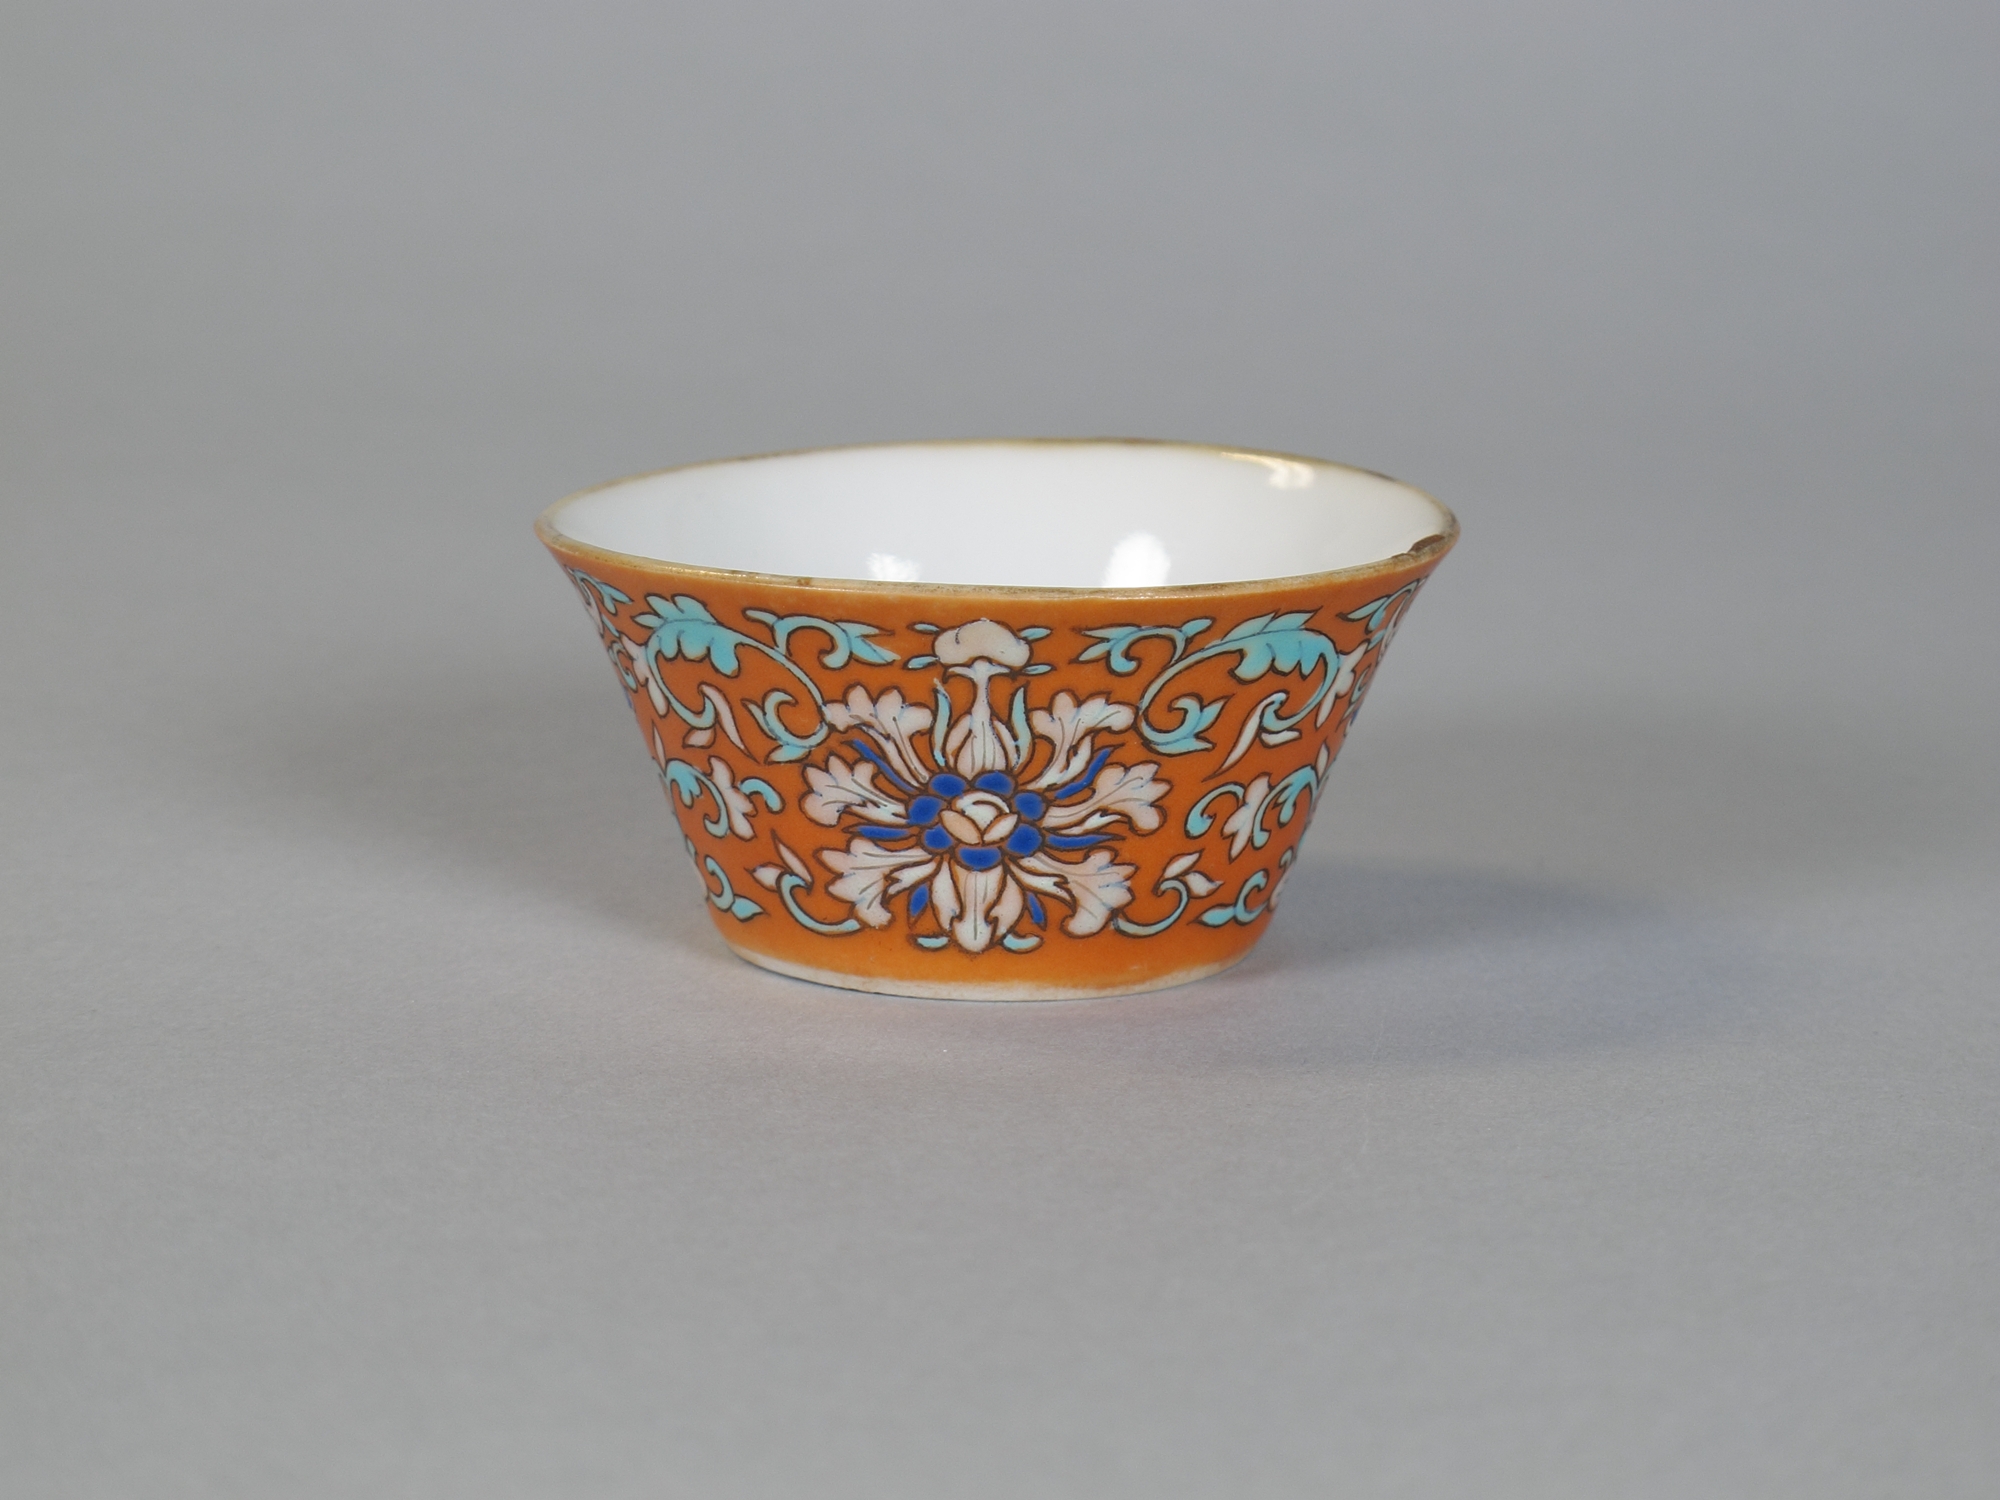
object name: cup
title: Cup (from a set of eight)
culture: chinese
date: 1644-1911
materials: enamel, glaze, iron, porcelain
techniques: overglaze, painting, polychrome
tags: flowers